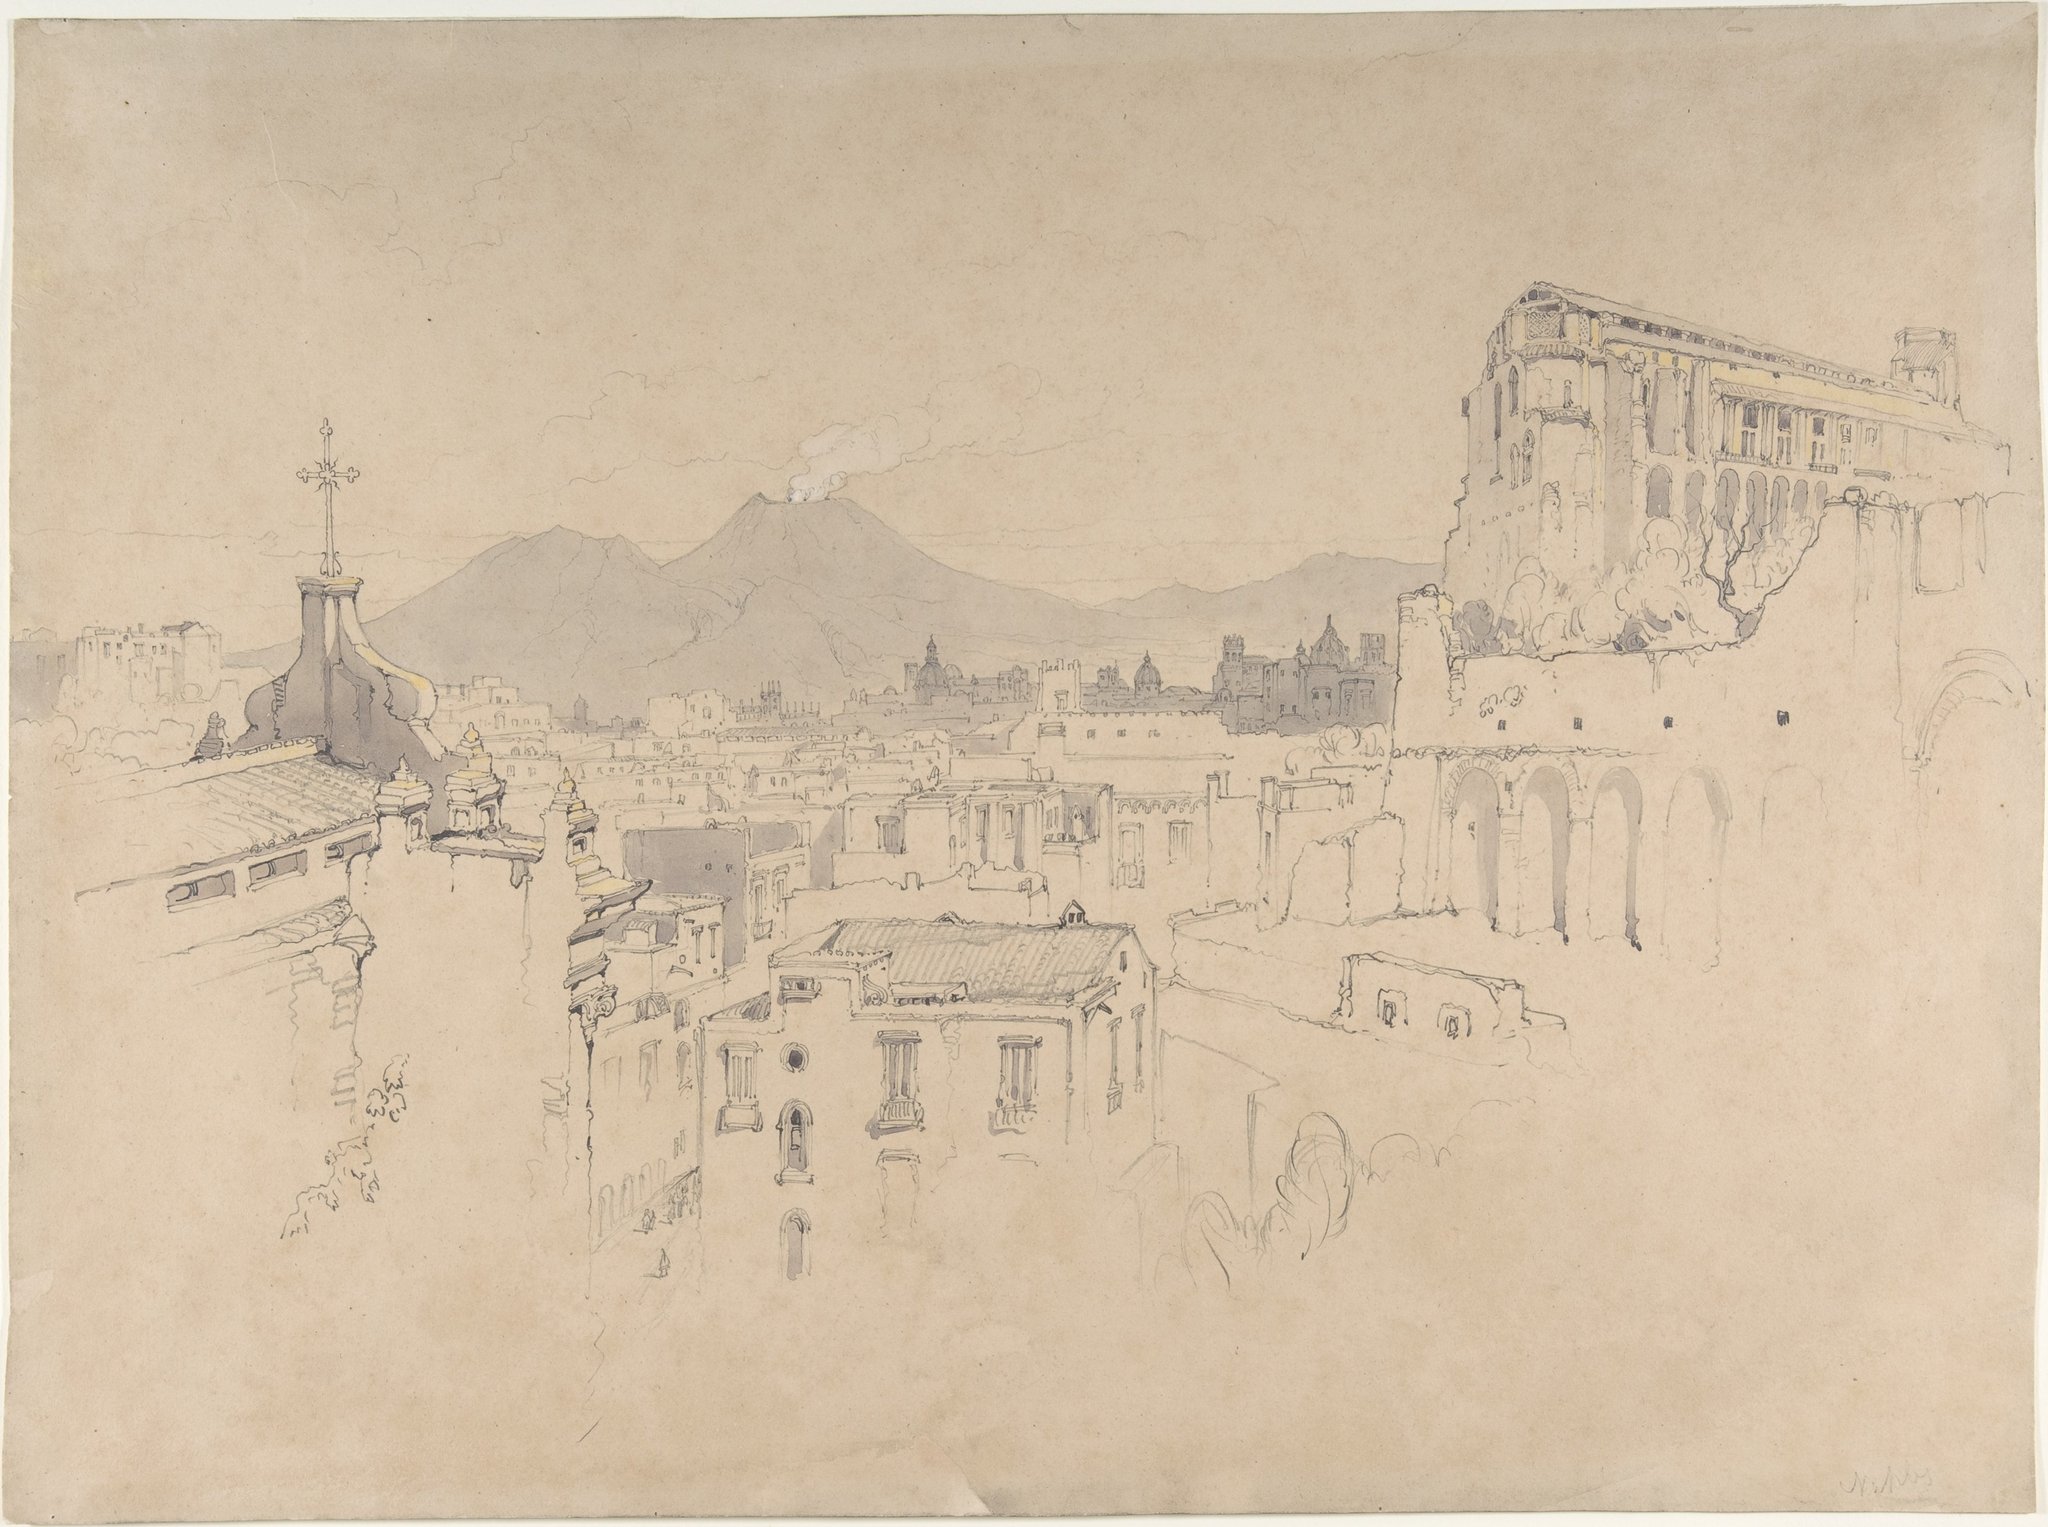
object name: drawing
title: Naples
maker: john ruskin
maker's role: artist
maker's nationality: british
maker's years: 1819-1900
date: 1841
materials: watercolor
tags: buildings,cities,volcanoes,cross